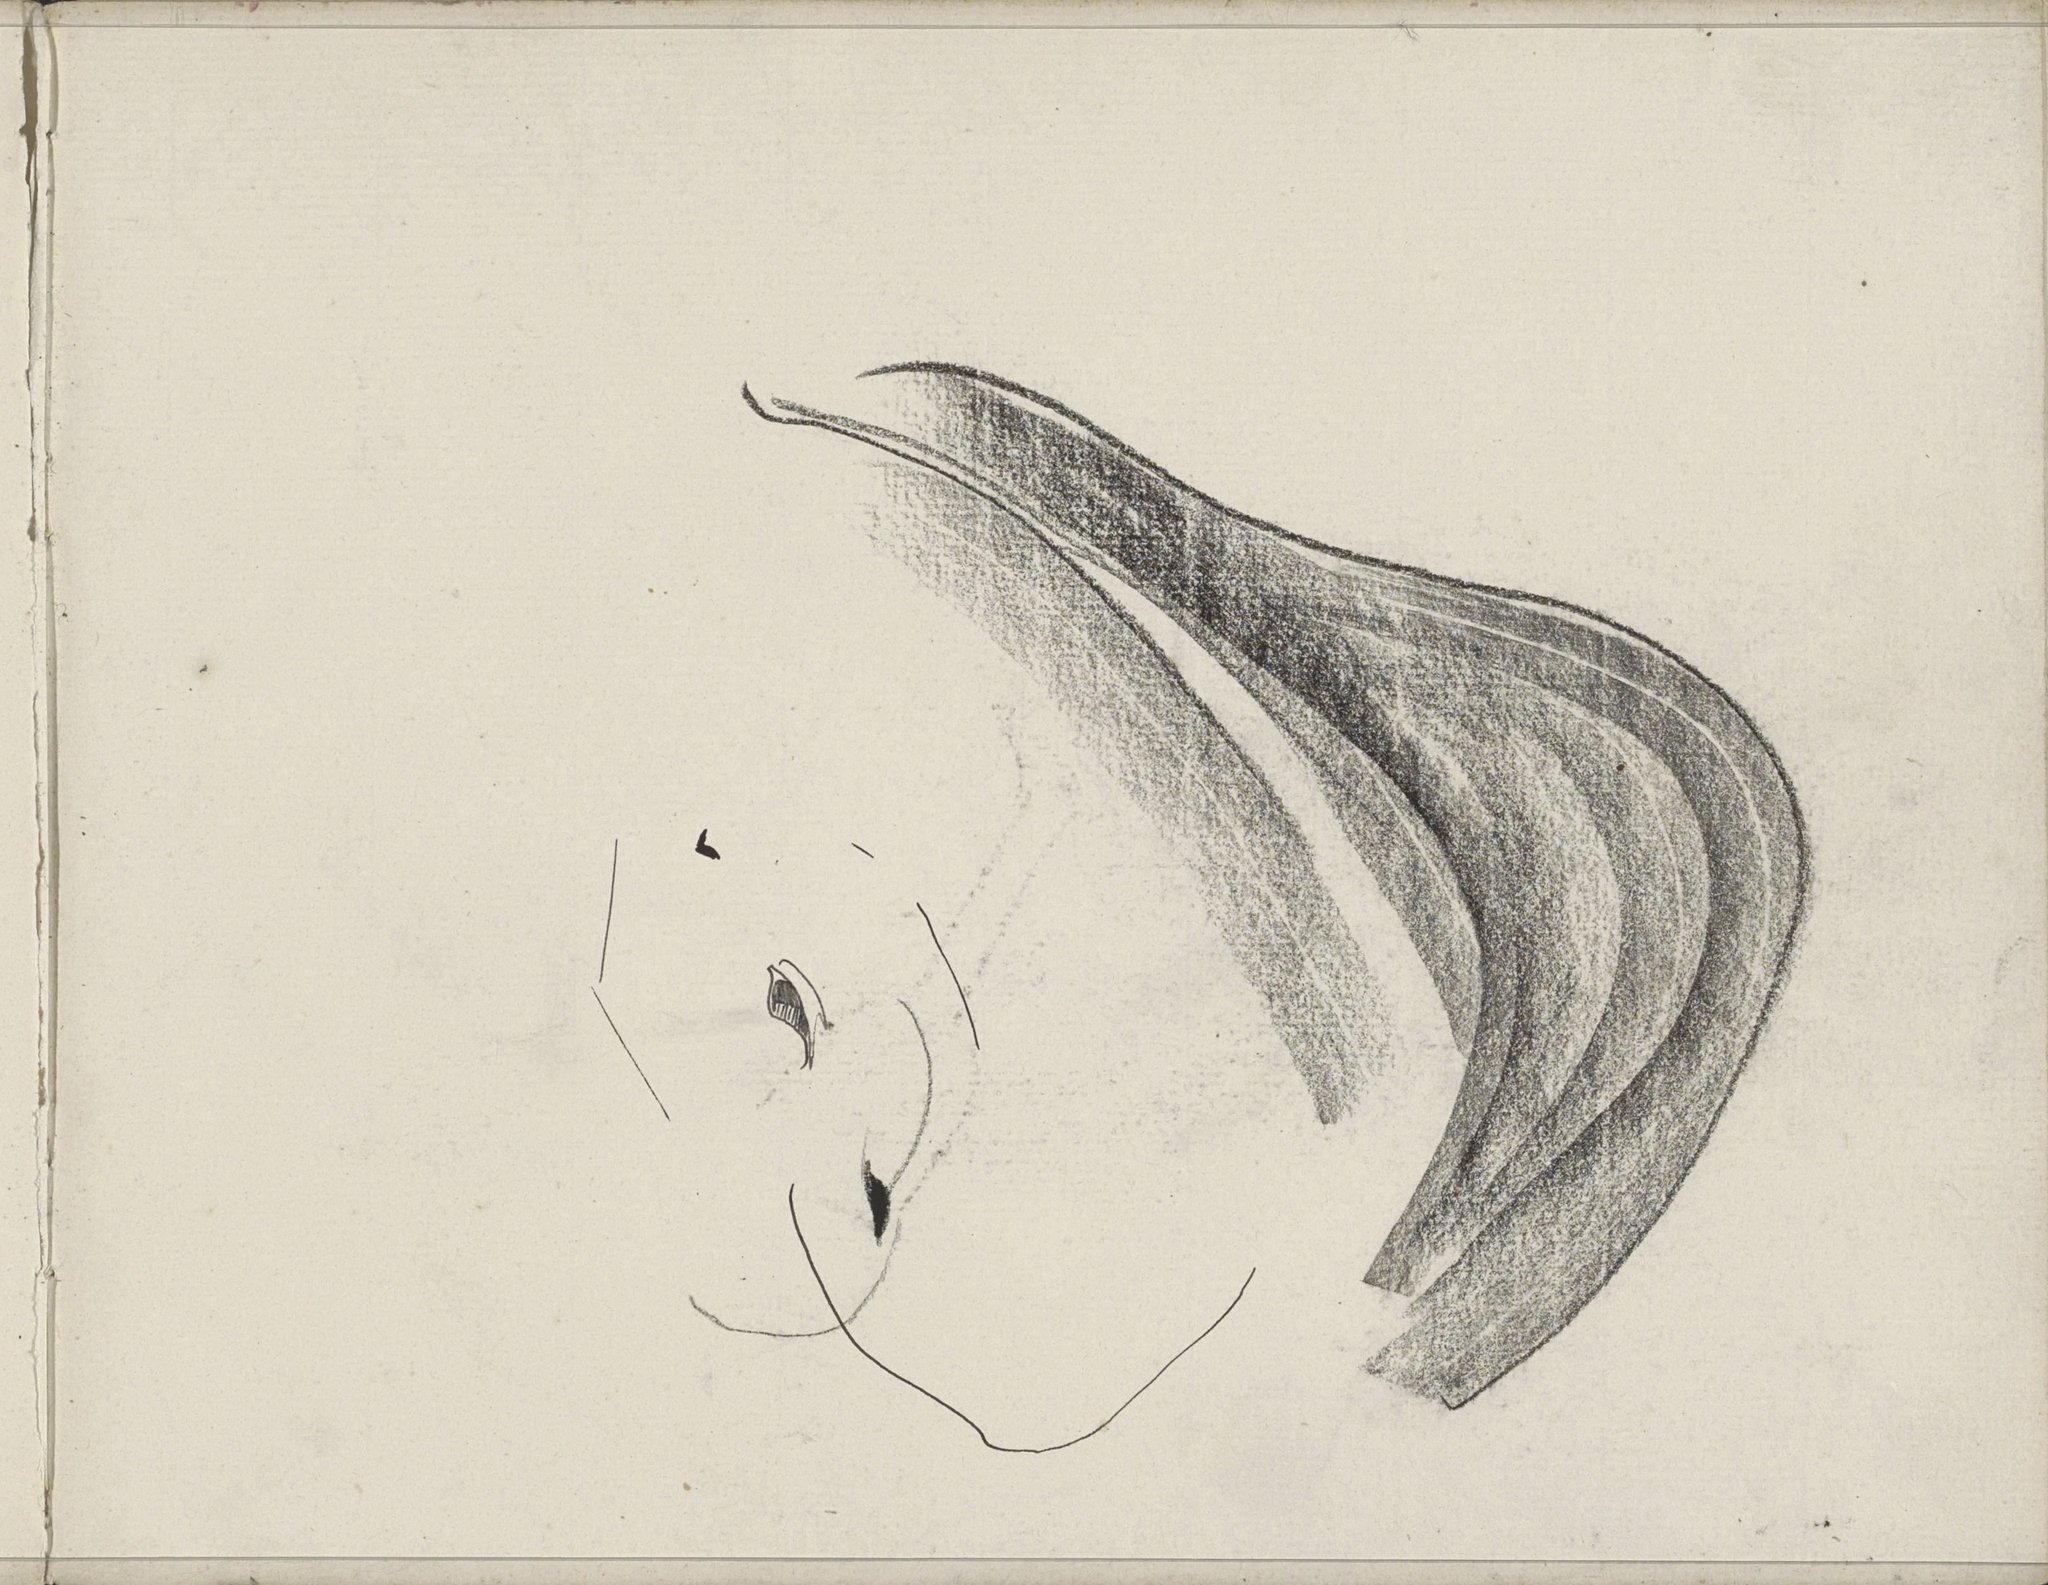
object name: sketchbook leaf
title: Studies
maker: carel adolph lion cachet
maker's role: draughtsman, print maker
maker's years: 1864-1945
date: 1896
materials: chalk, ink, paper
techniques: pen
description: Blad 35 recto uit een schetsboek met 44 bladen.